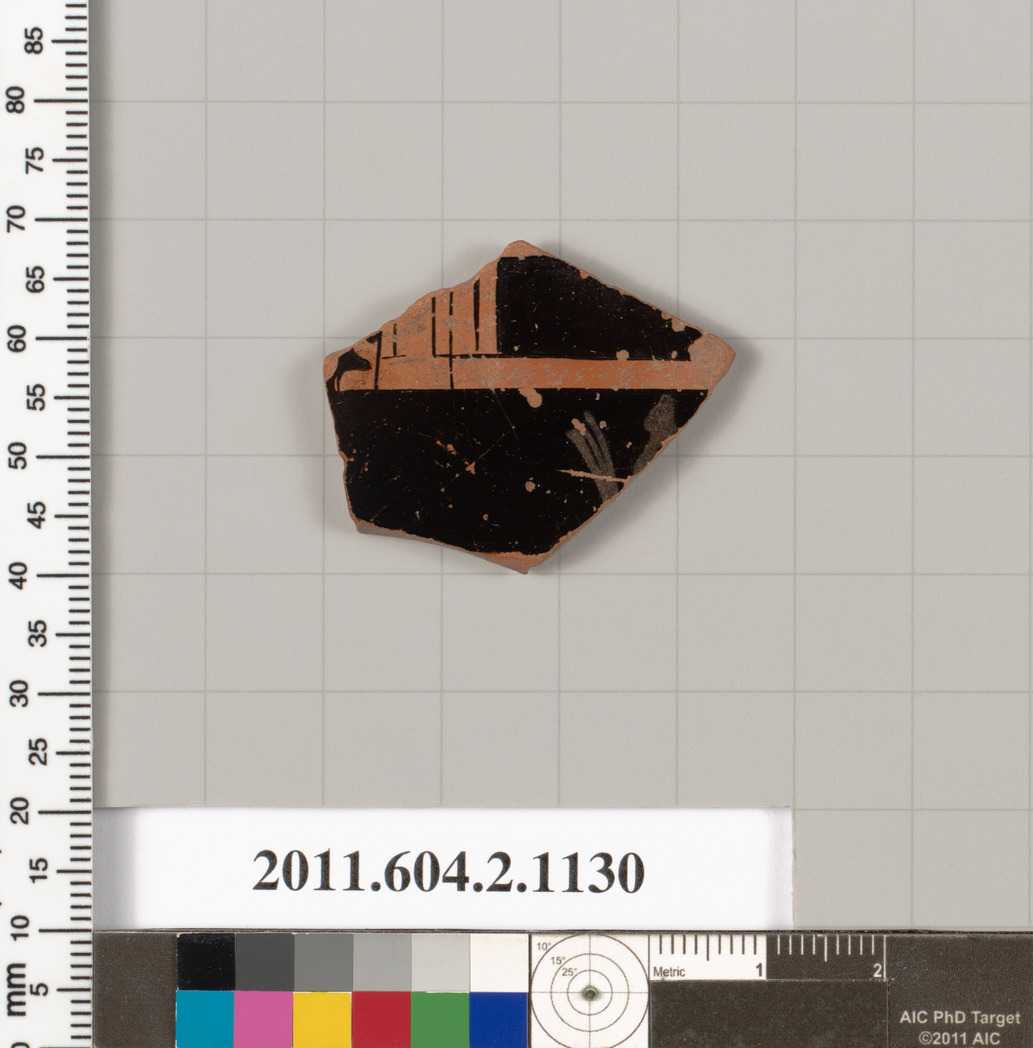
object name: lekythos fragment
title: Terracotta fragment of a lekythos (oil flask)?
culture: greek, attic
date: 460-440 BCE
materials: terracotta